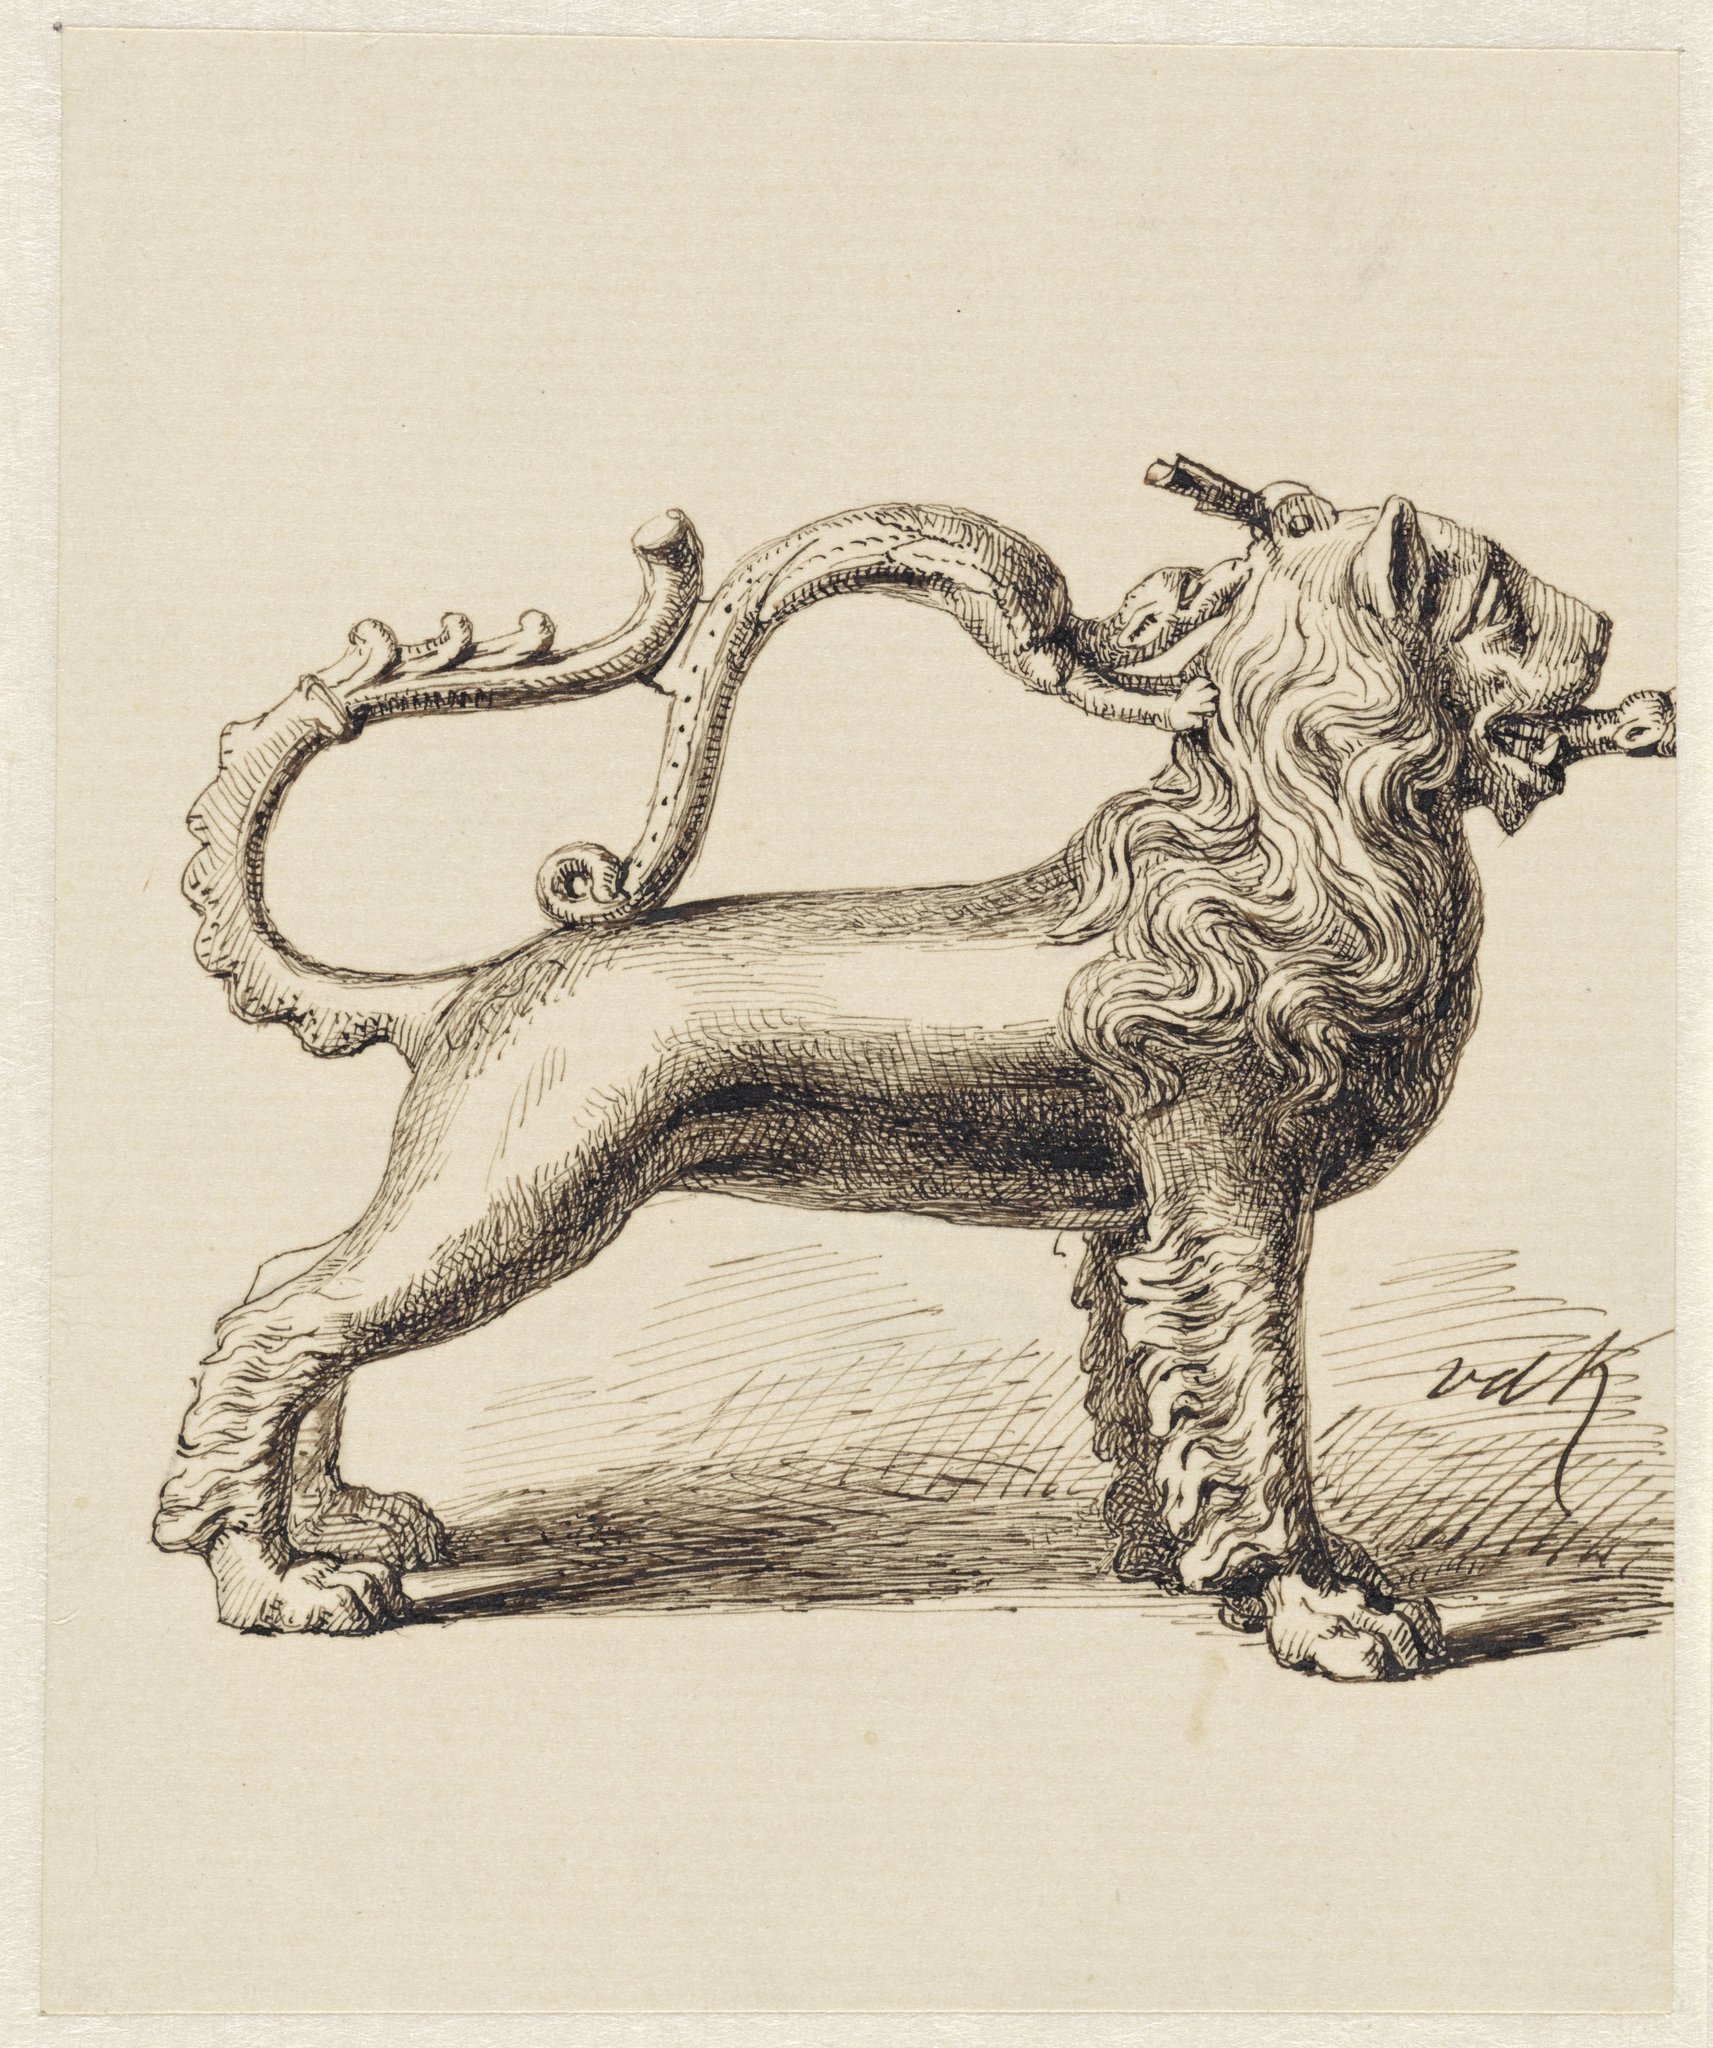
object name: drawing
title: Bronzen schenkkan in de vorm van een leeuw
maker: david van der kellen (1827-1895)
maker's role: draughtsman, print maker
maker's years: 1827-1895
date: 1837-1895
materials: ink, paper, pencil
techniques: pen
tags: beasts of prey, predatory animals: lion, container of metal: bucket, can, canister, drum, tin